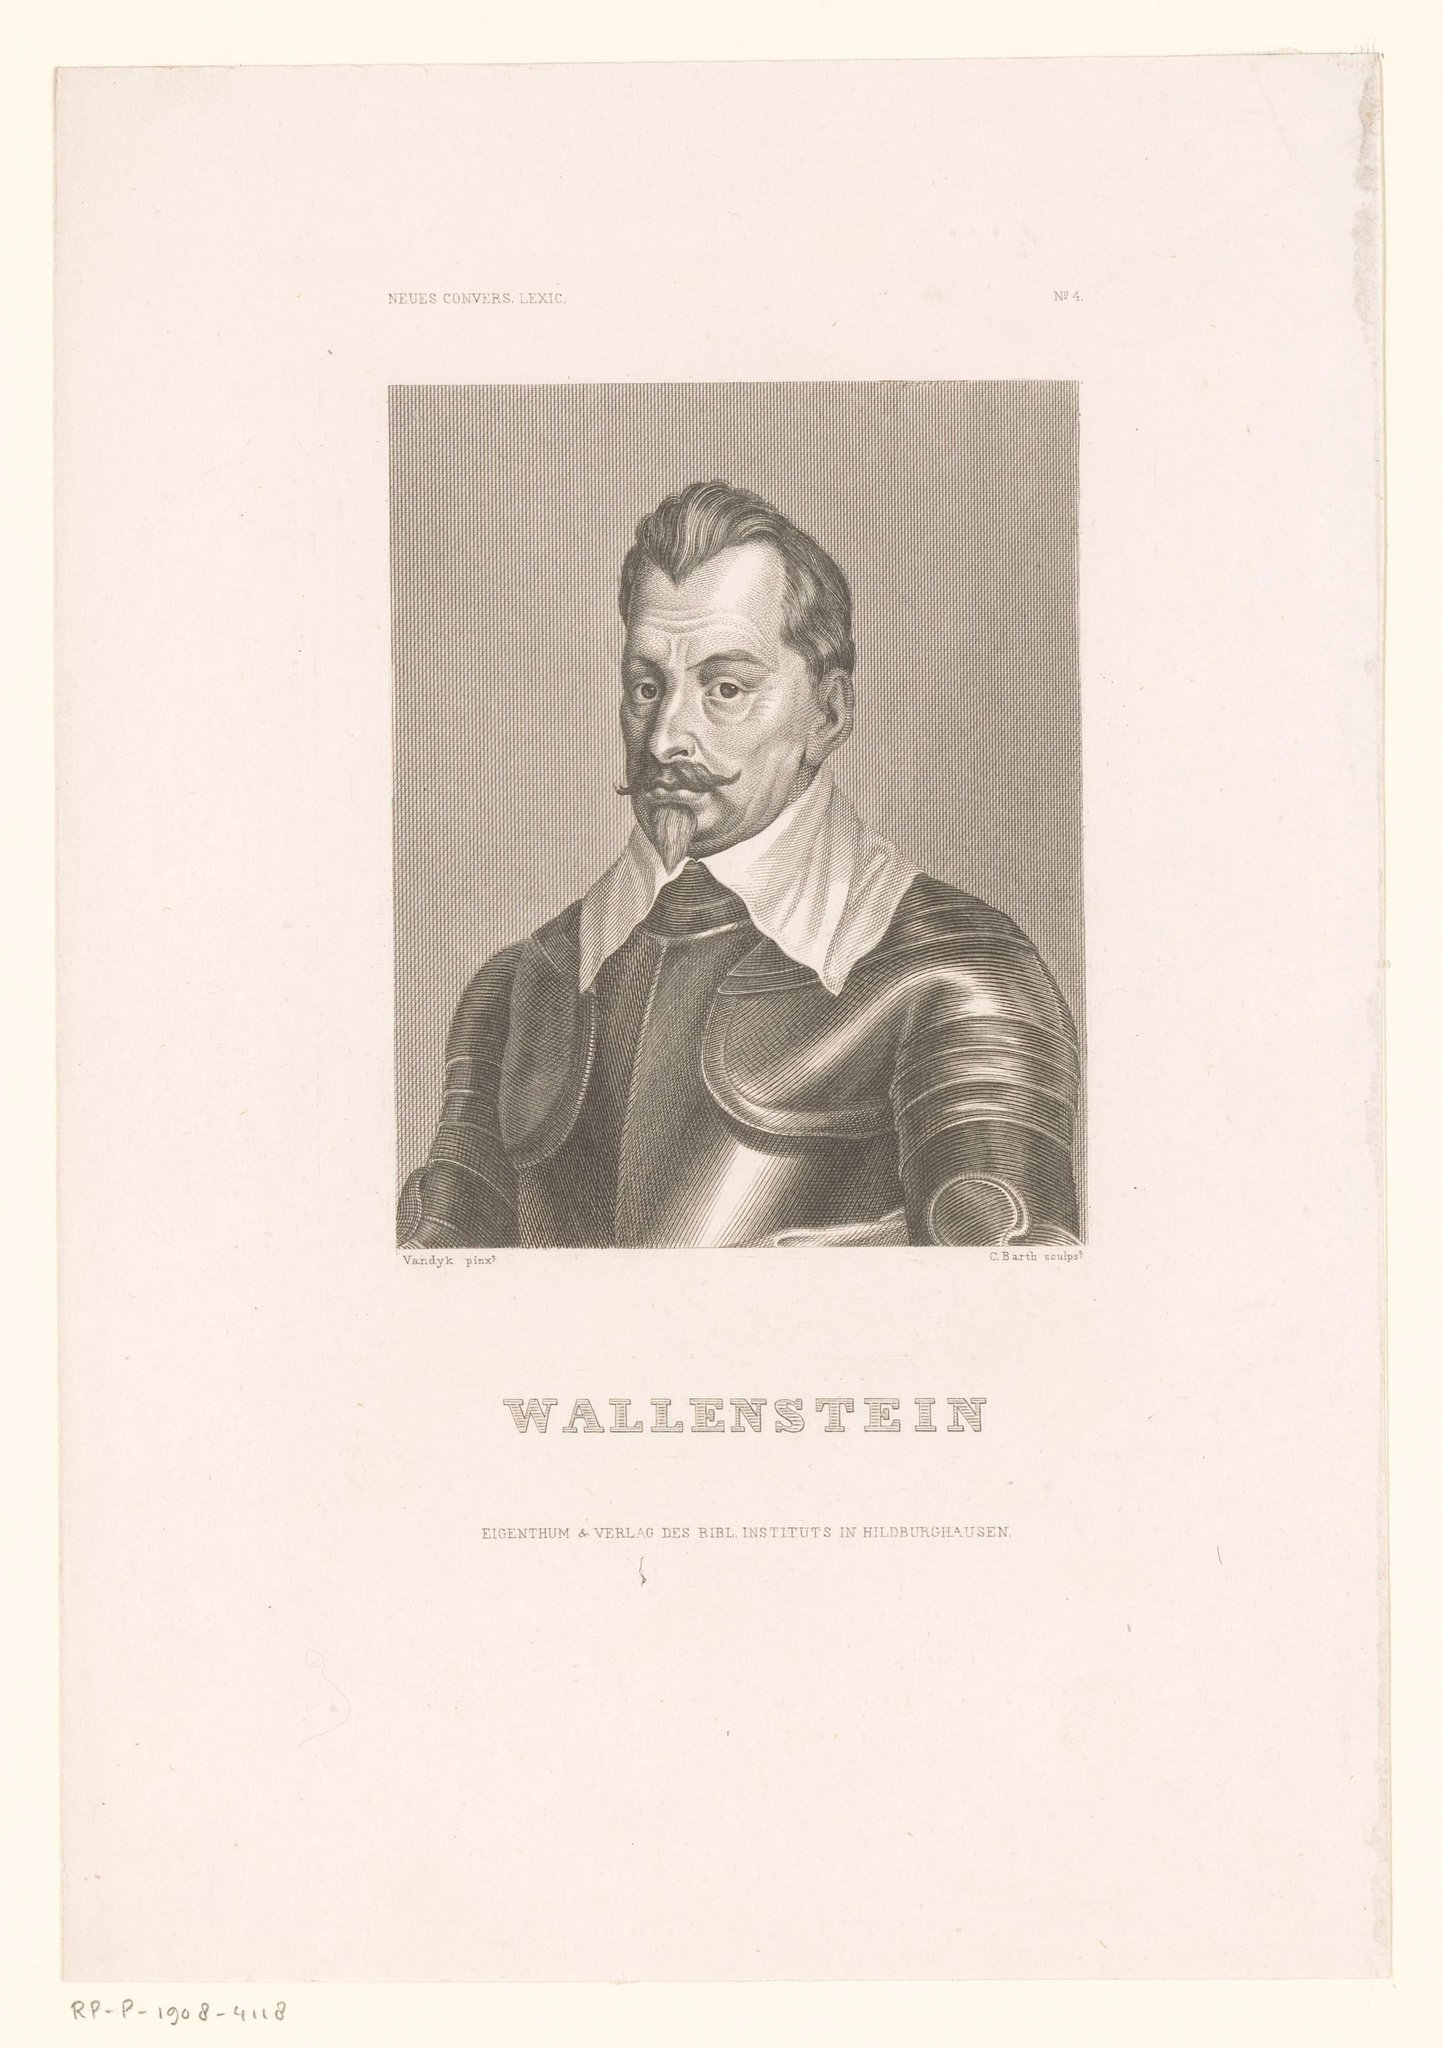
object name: print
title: Portret van Albrecht von Wallenstein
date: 1828-1853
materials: paper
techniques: engraving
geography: hildburghausen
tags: historical persons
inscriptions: collector's mark: Lugt 2228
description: Prent afkomstig uit: Meyers Neues Conversations-Lexikon für alle Stände, voor het eerst uitgegeven tussen 1857-1861.